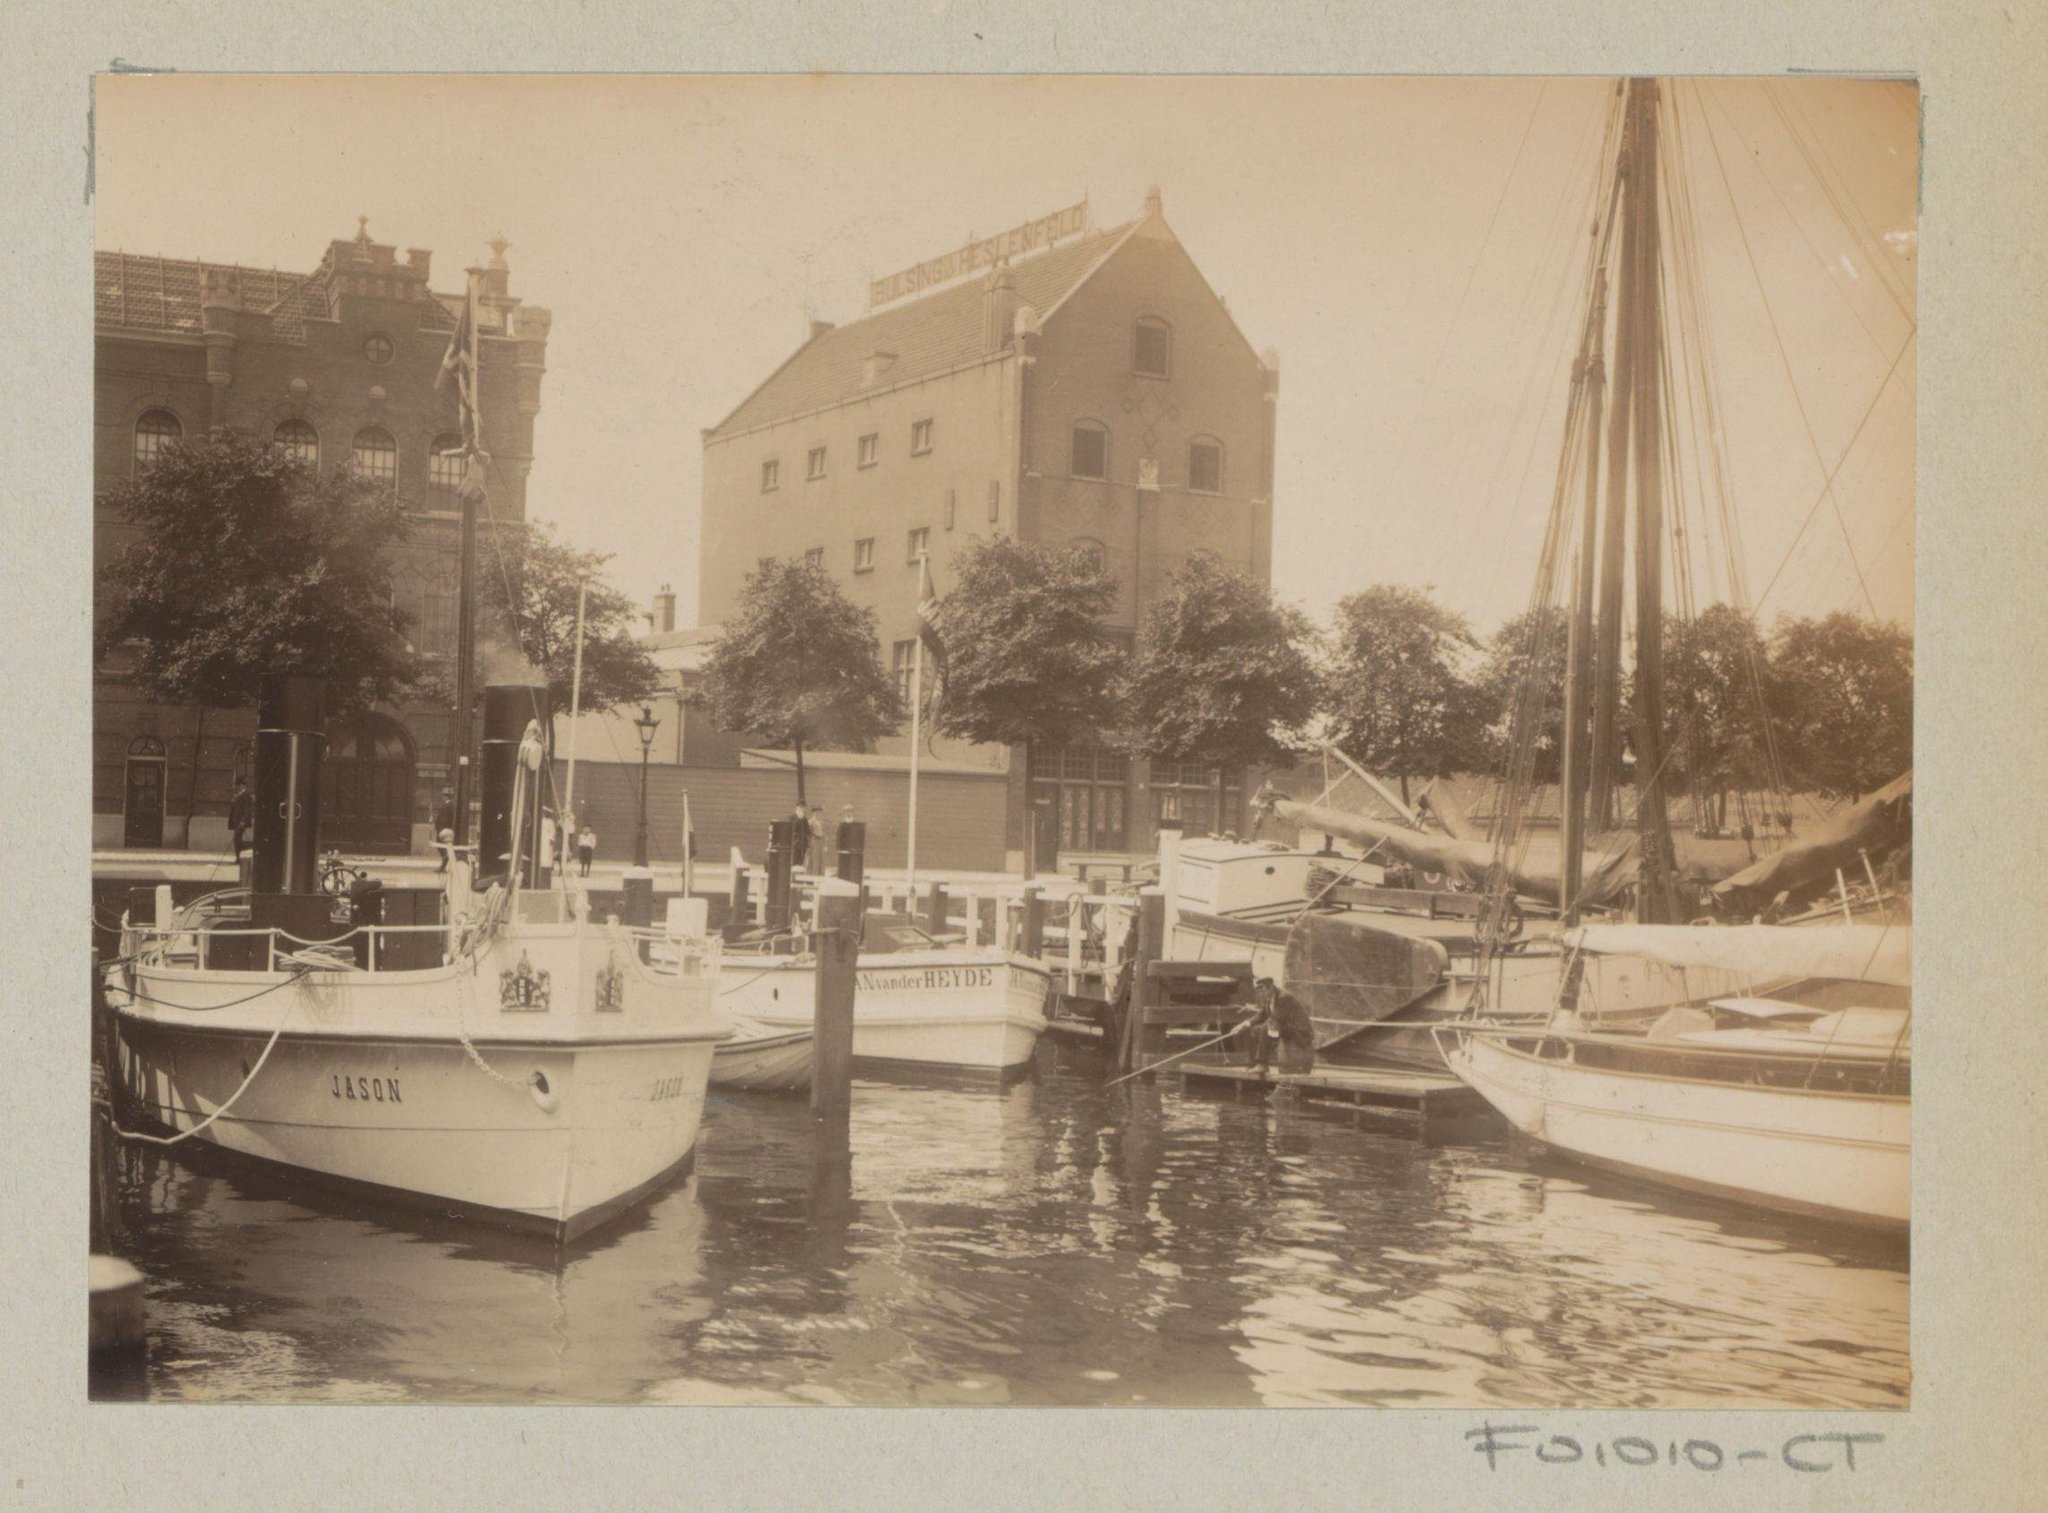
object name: photograph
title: Blusboten Jan van der Heyde en Jason aan de De Ruijterkade te Amsterdam, op de achtergrond het meelpakhuis van Bulsing en Heslenfeld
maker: Anonymous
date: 1904-1910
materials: photographic support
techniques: gelatin silver print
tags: harbour, warehouse (~ harbour), fire-department, fire-brigade, amsterdam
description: Onderdeel van Familiealbum met onder meer foto's van Wijnhandel Kraaij & Co. Bordeaux-Amsterdam.